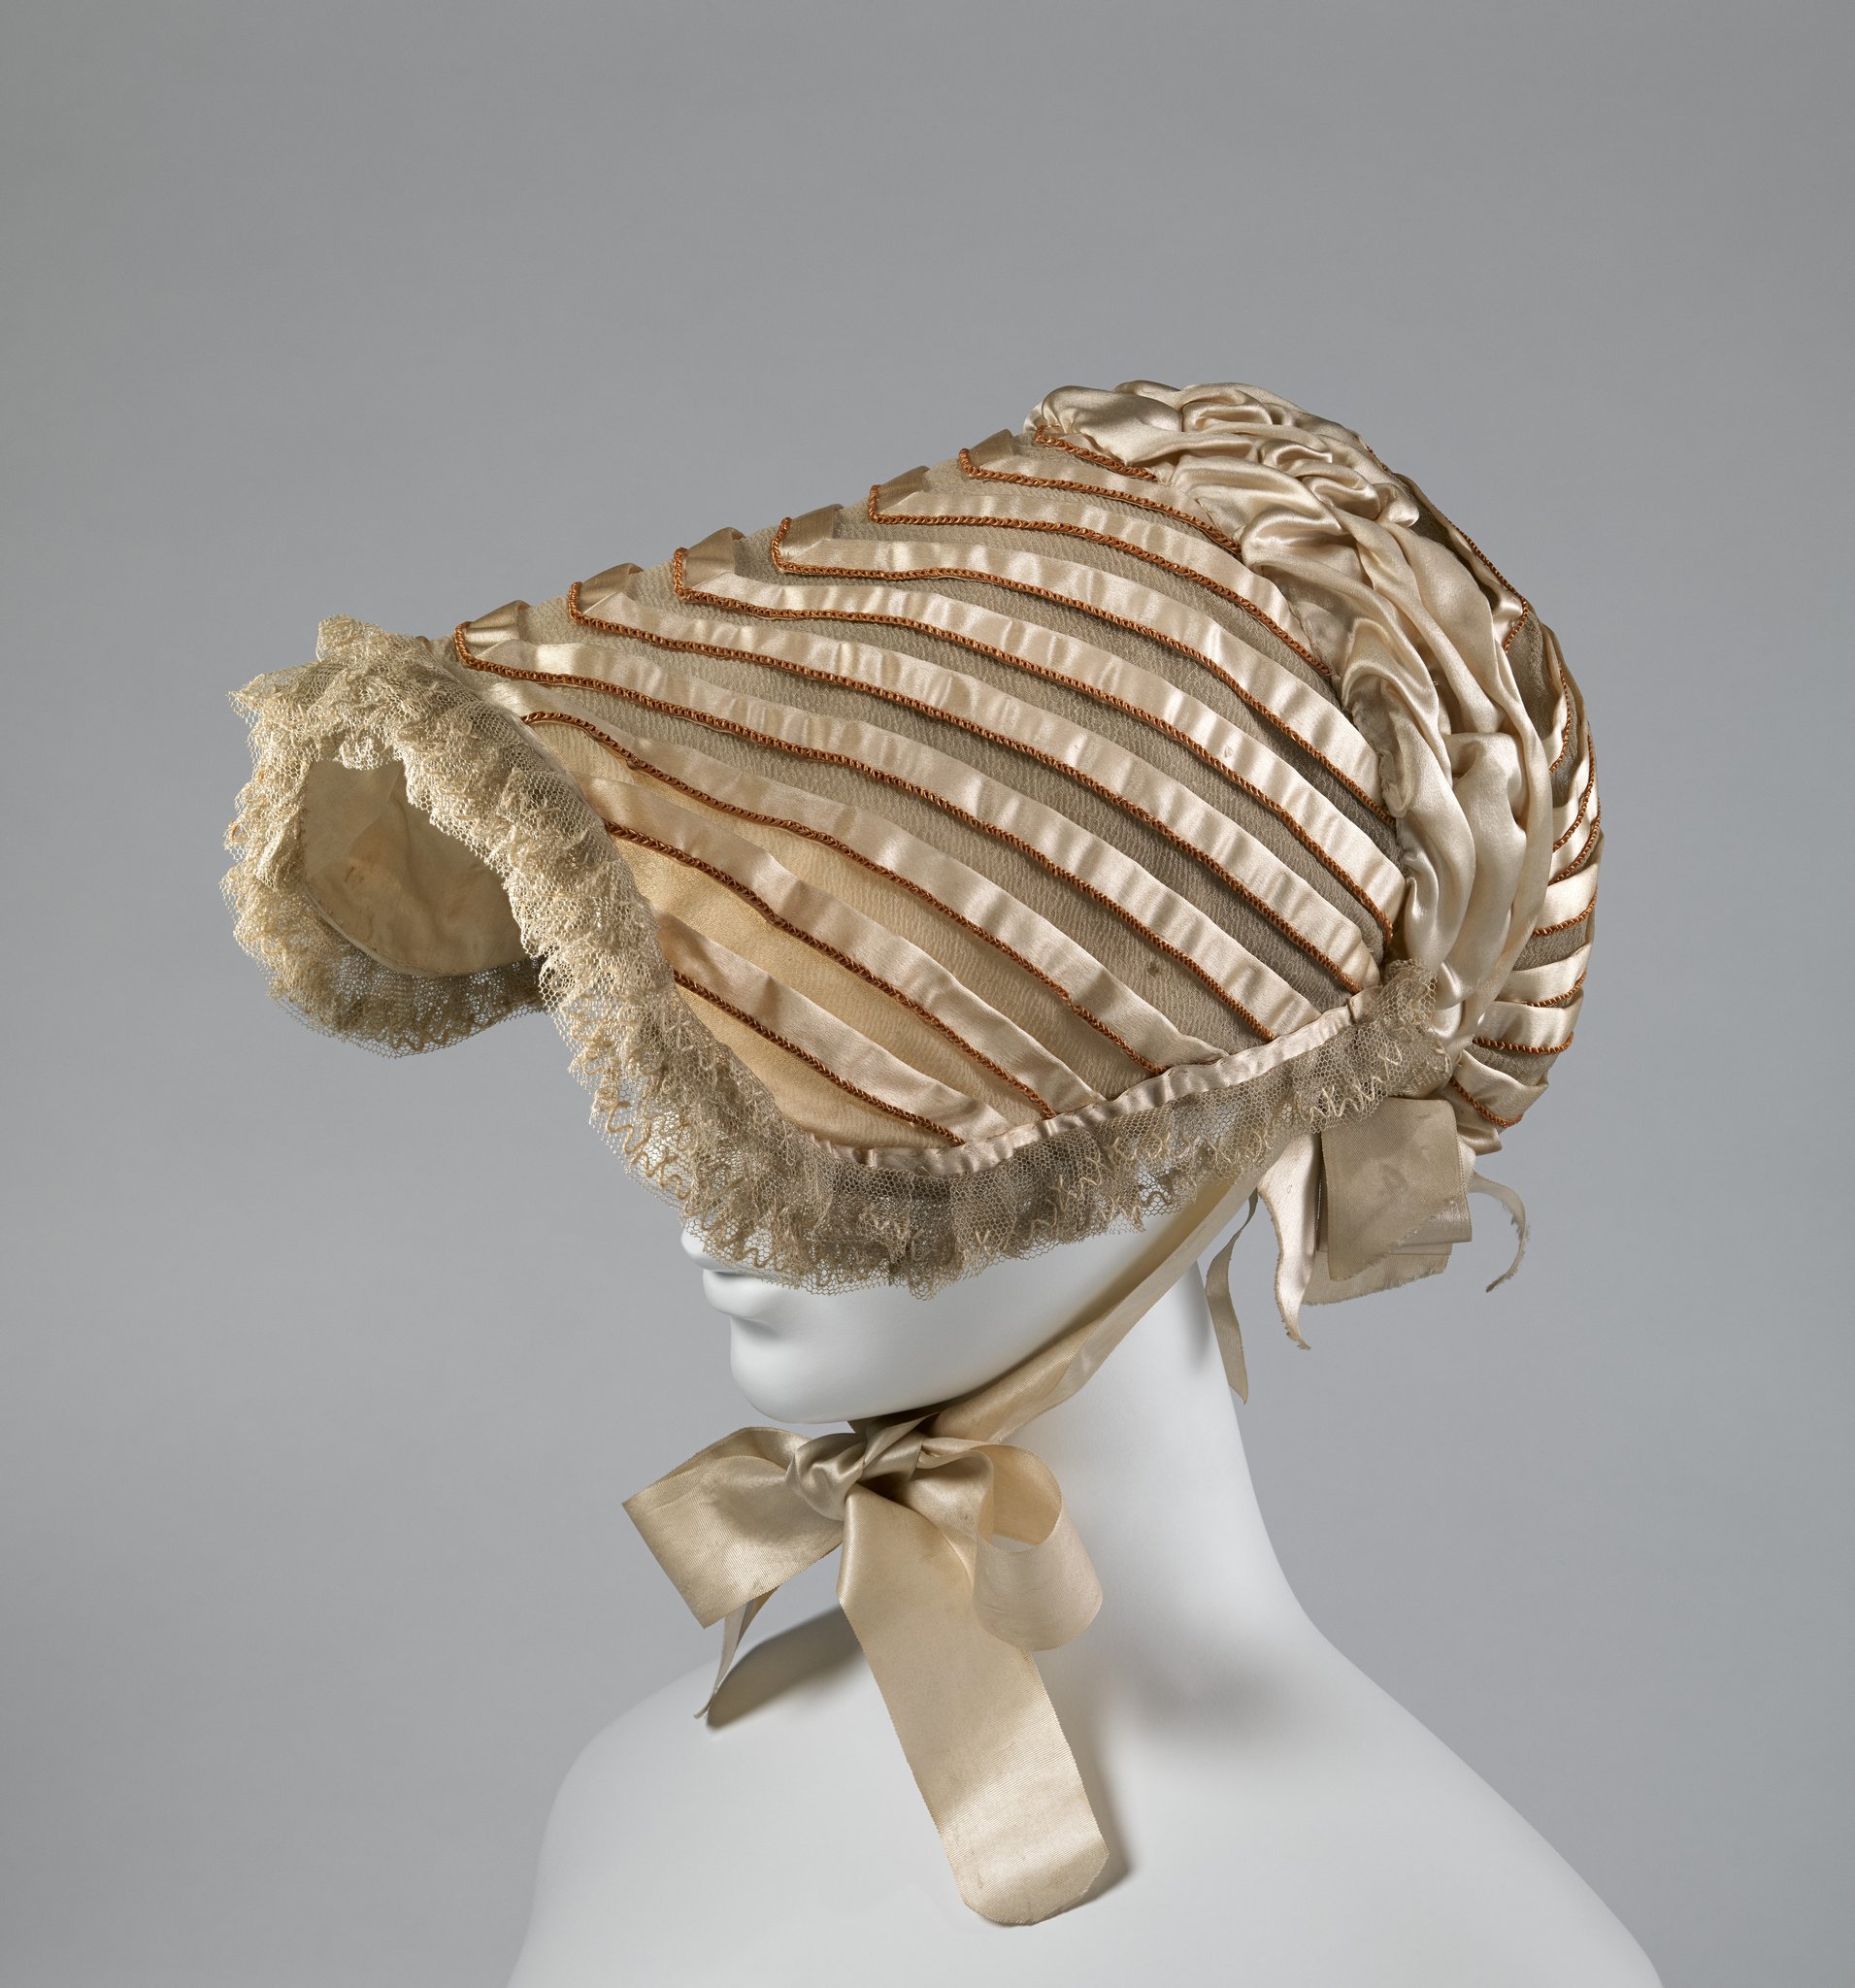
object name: hat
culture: french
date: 1806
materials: silk, fiber